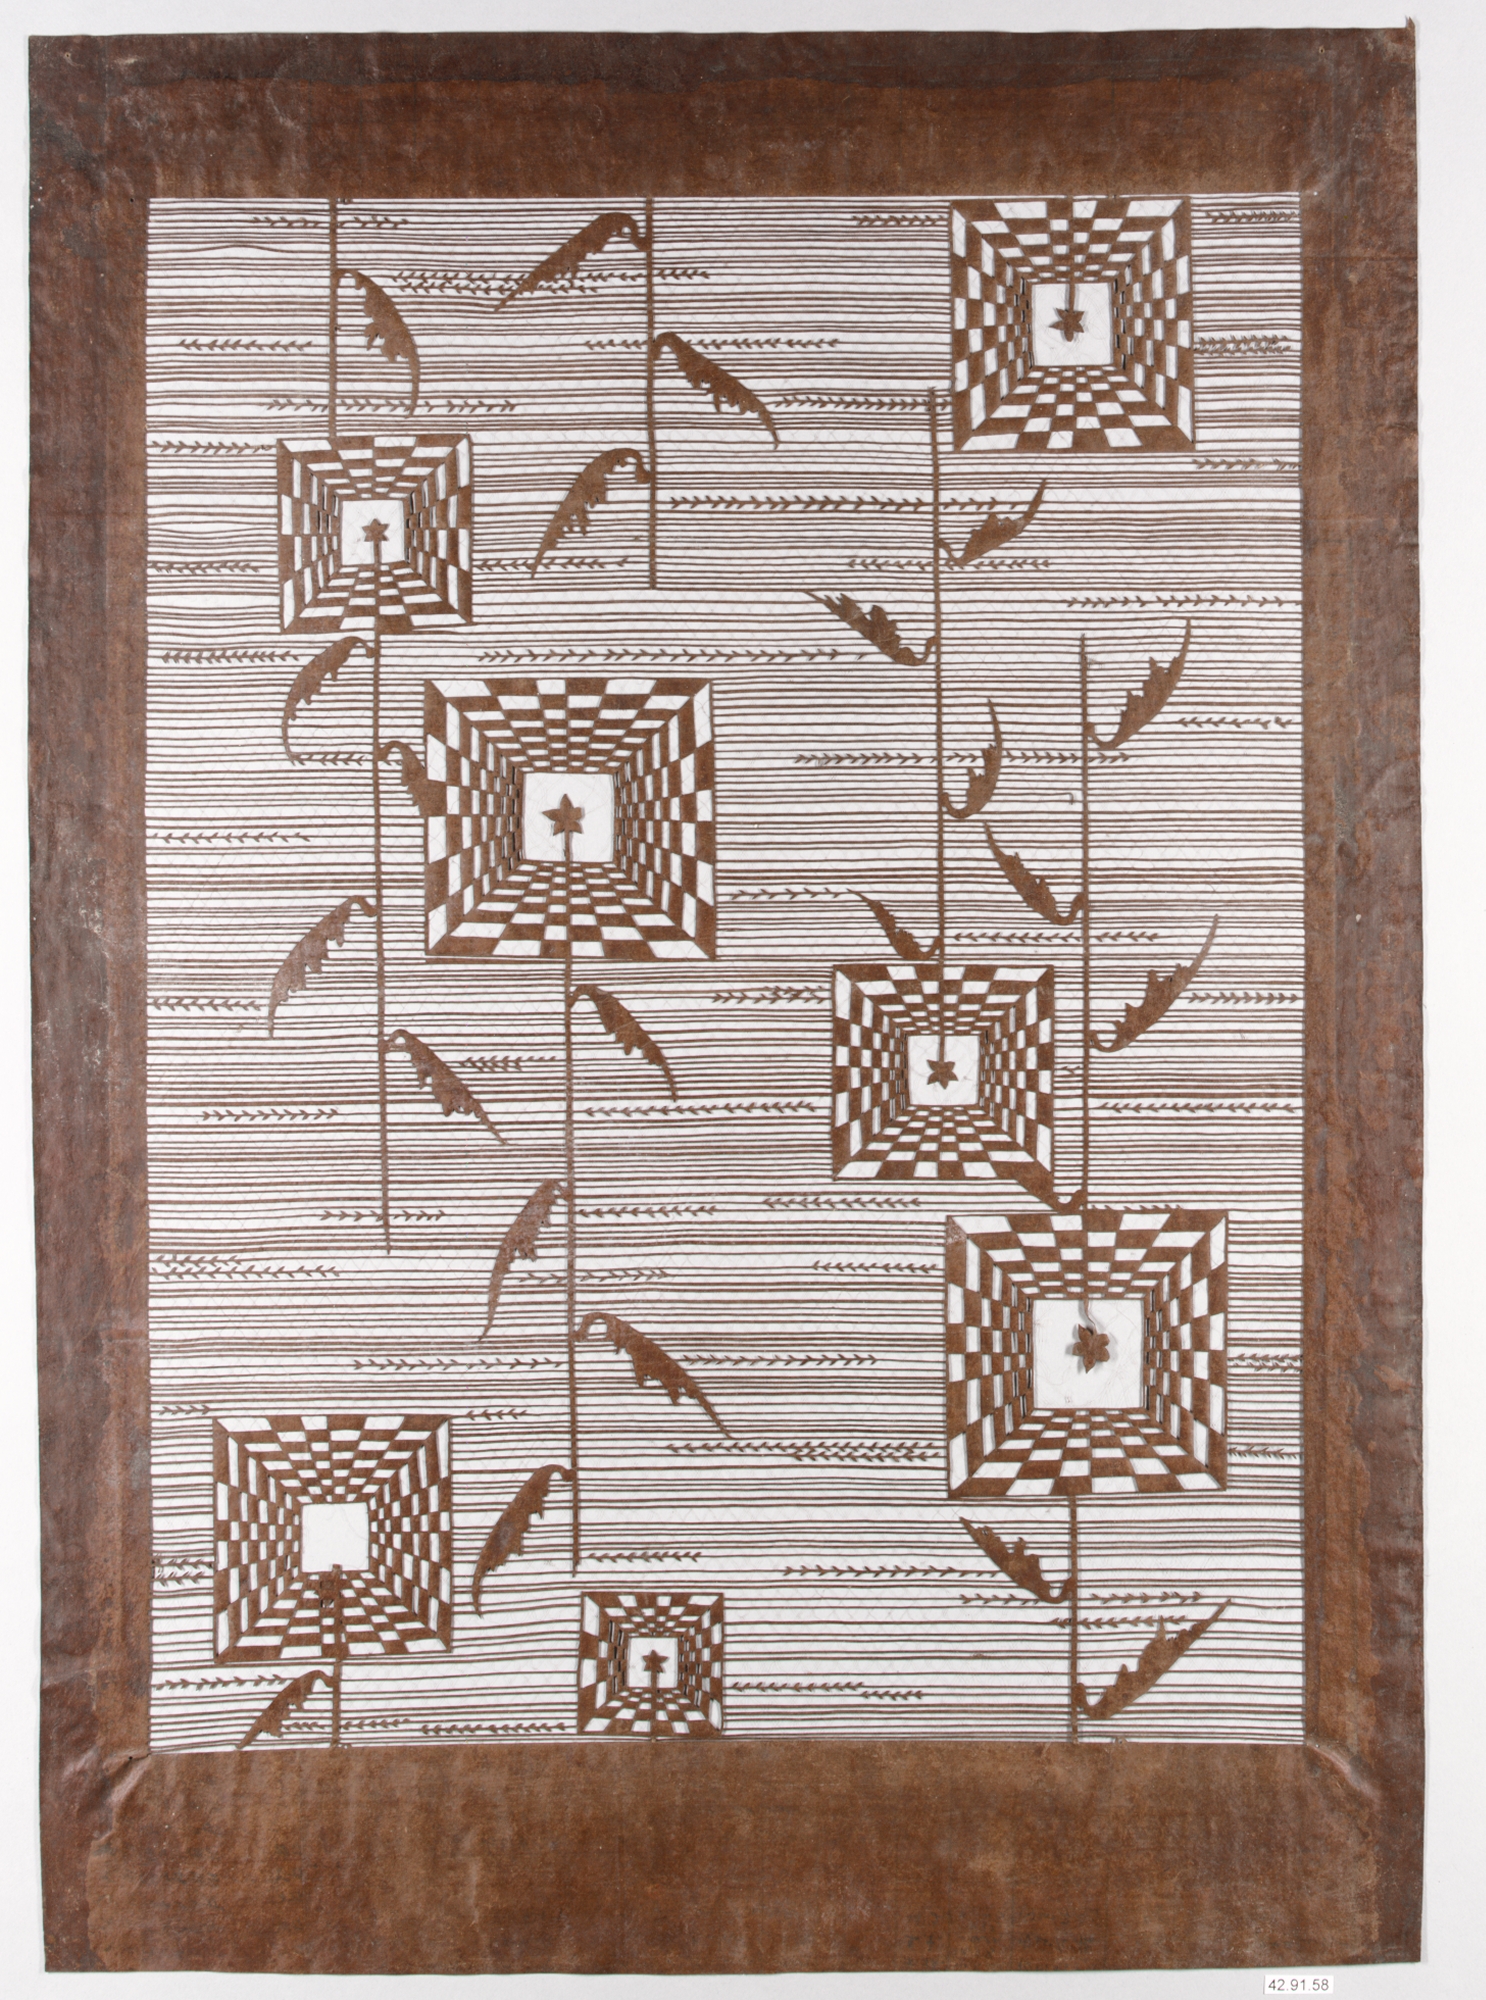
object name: stencil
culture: japanese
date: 1801-1900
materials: paper, silk